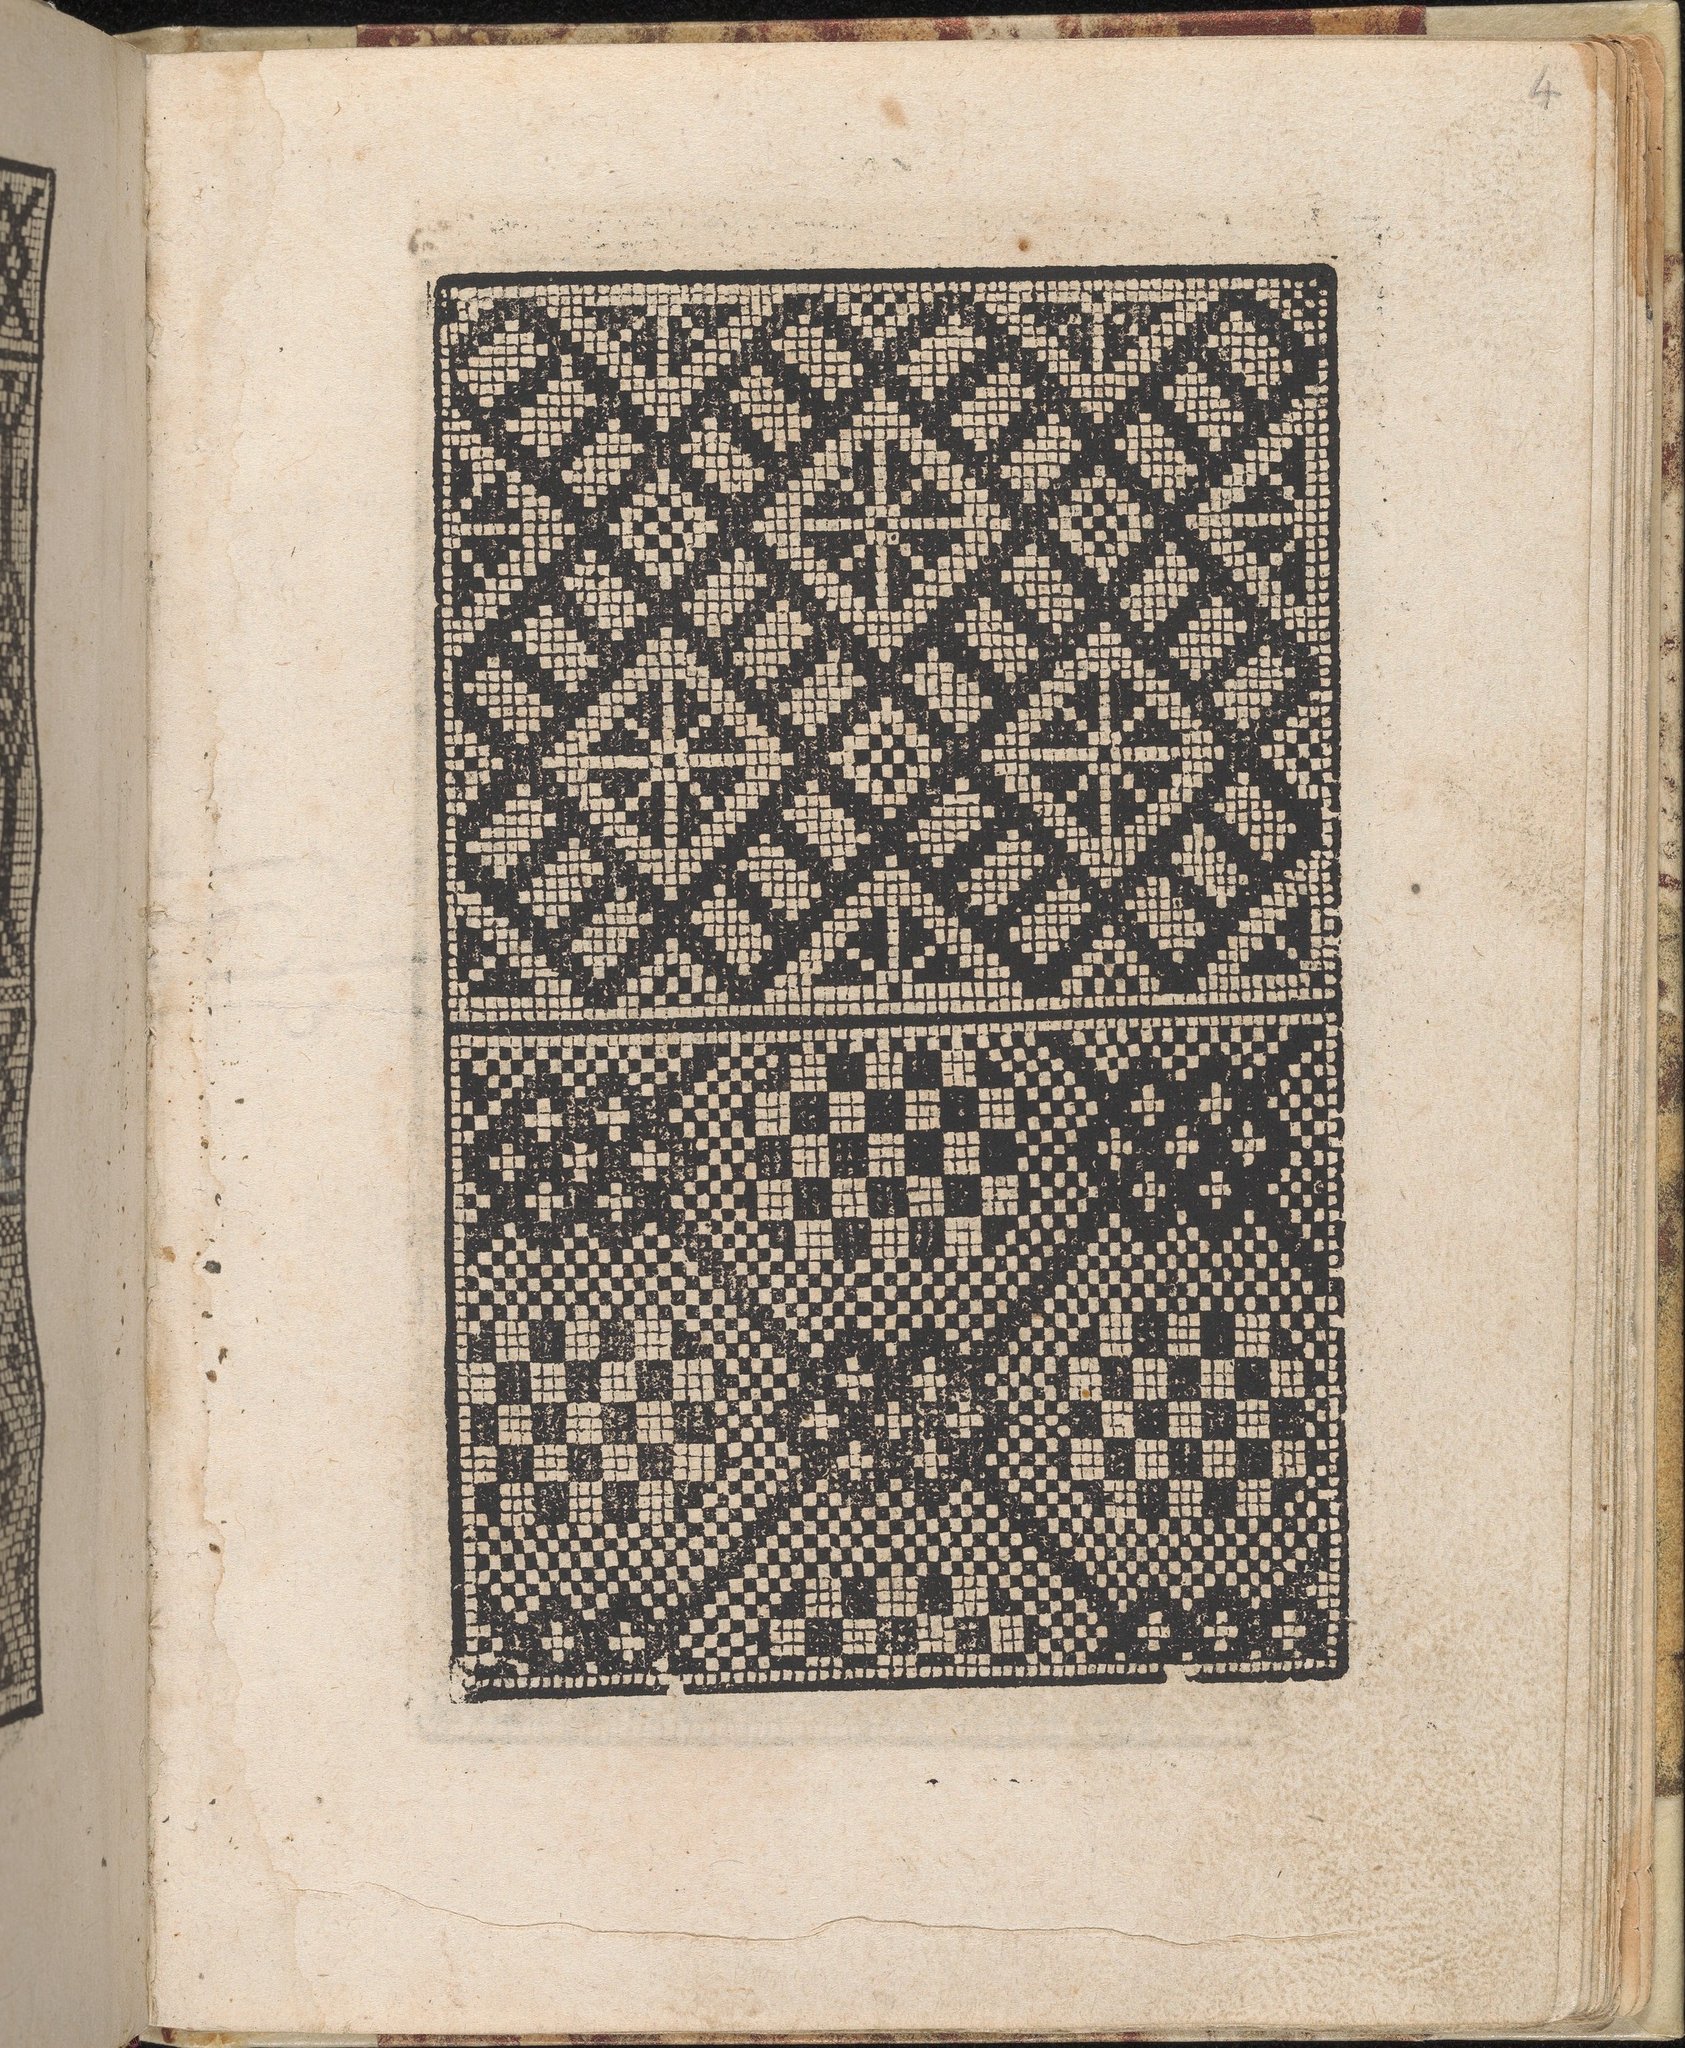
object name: book print ornament architecture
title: Ein new getruckt model Büchli...Page 3, verso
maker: johann schönsperger the younger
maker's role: publisher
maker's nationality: german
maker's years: 1490-1550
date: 1529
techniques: woodcut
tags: ornament